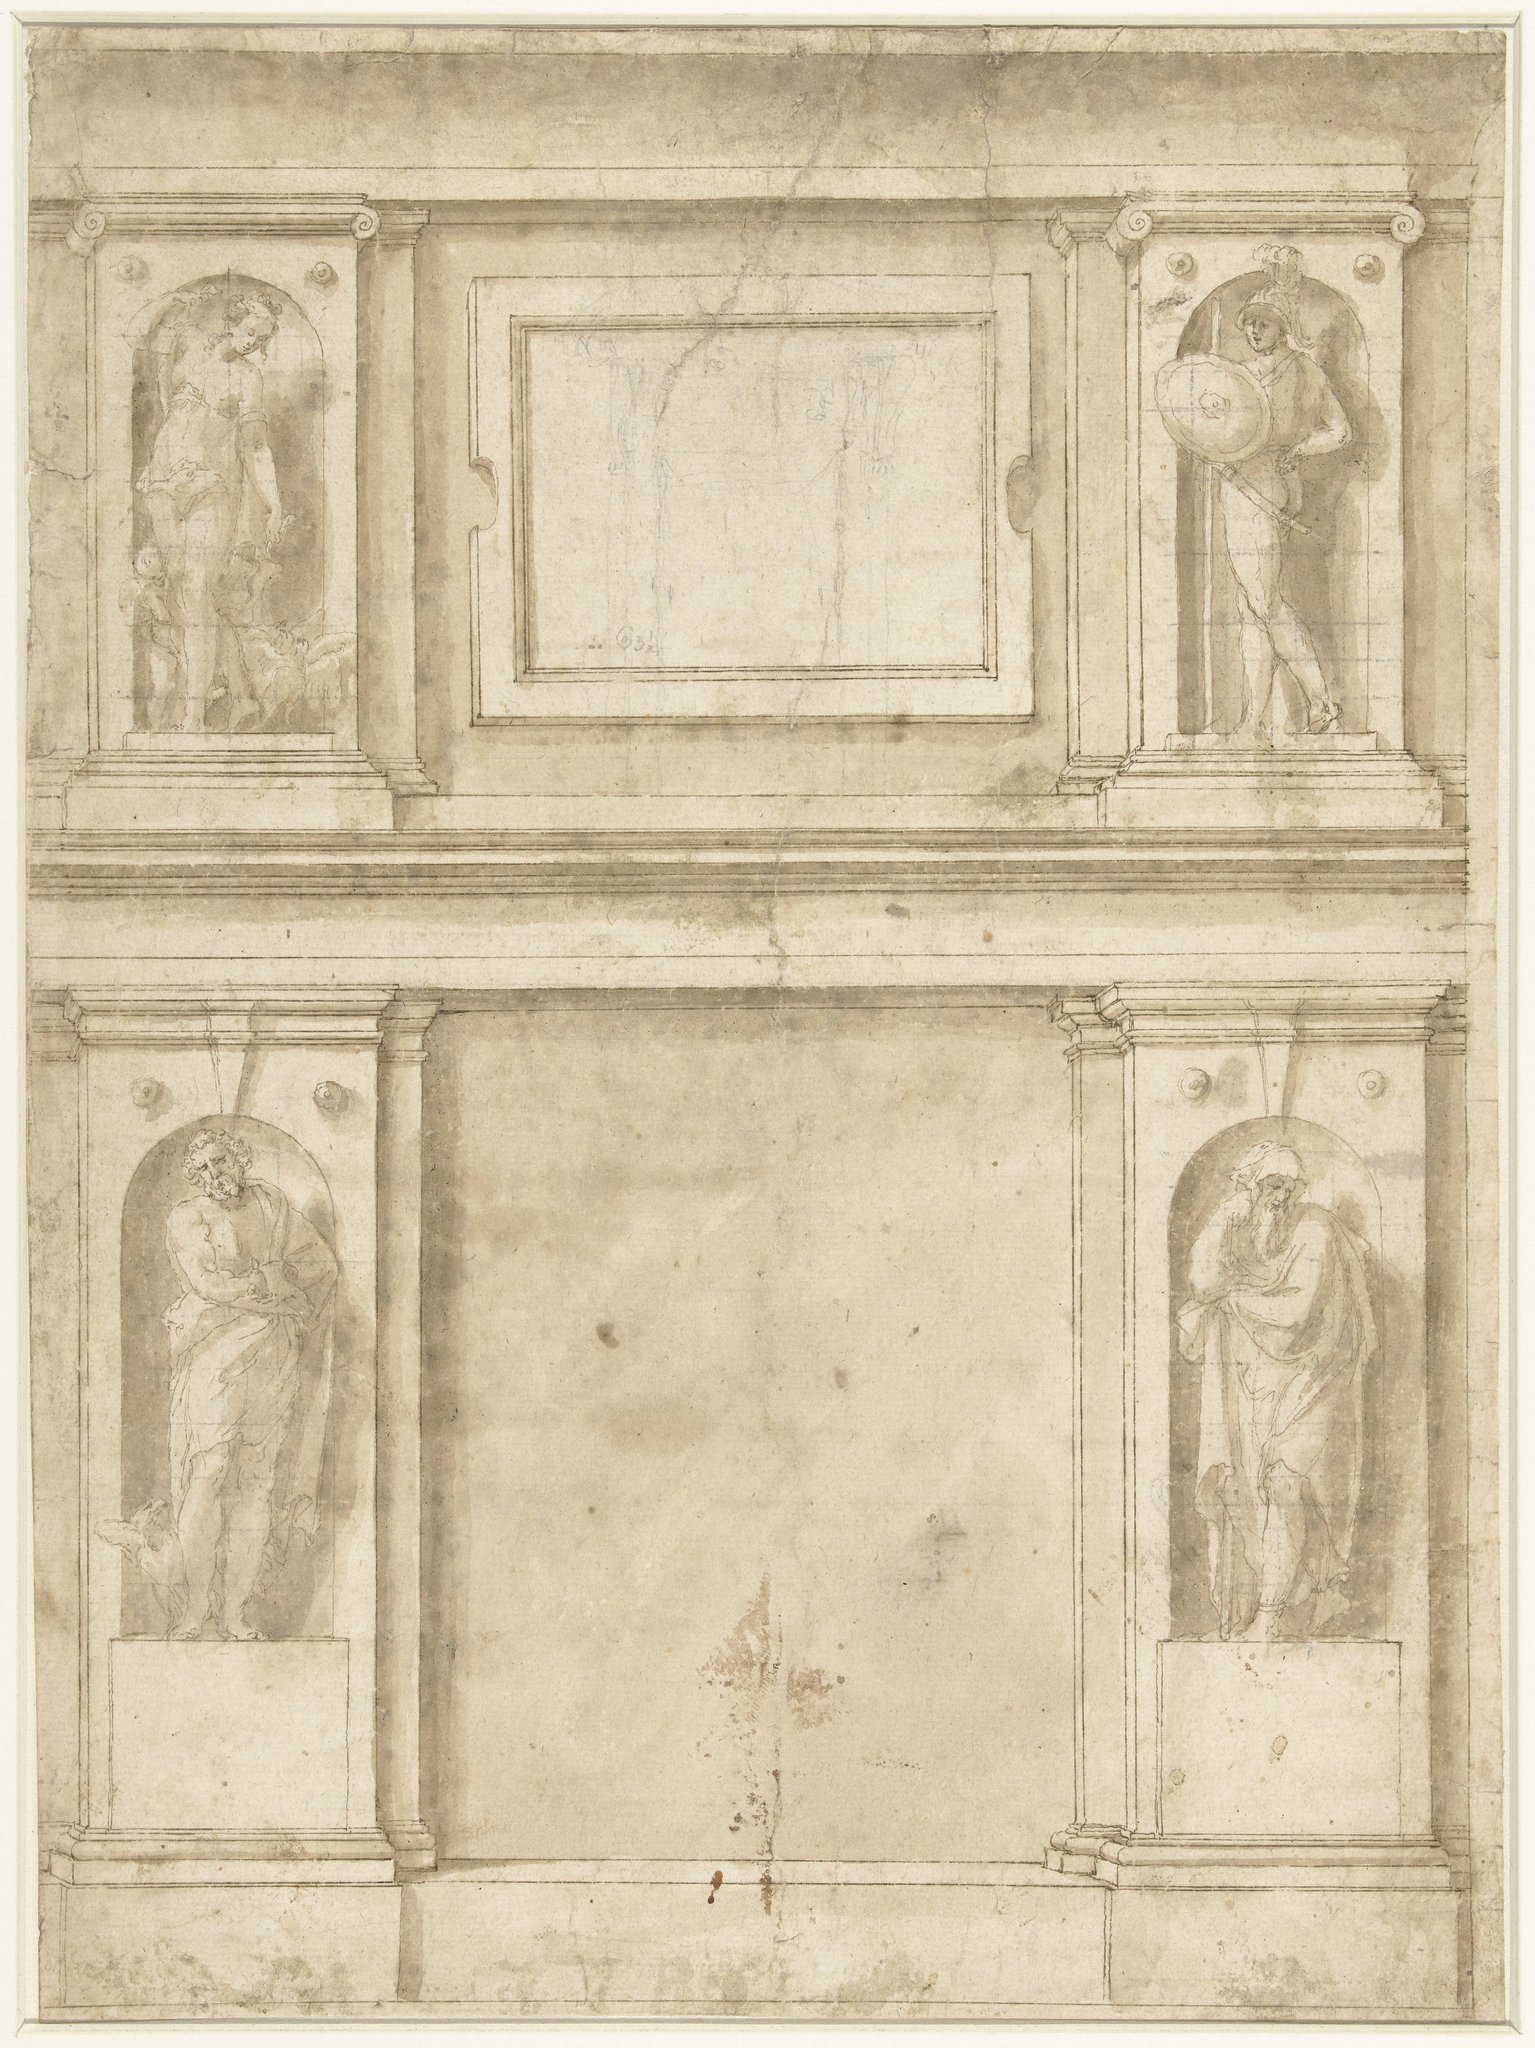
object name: design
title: Ontwerp voor de indeling van een muurvlak, met beelden van Mars en Venus, en Jupiter en Saturnus (?)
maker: lelio orsi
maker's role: draughtsman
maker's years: 1511-1587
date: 1521-1587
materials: ink, paper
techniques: brush, pen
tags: mars and venus as lovers